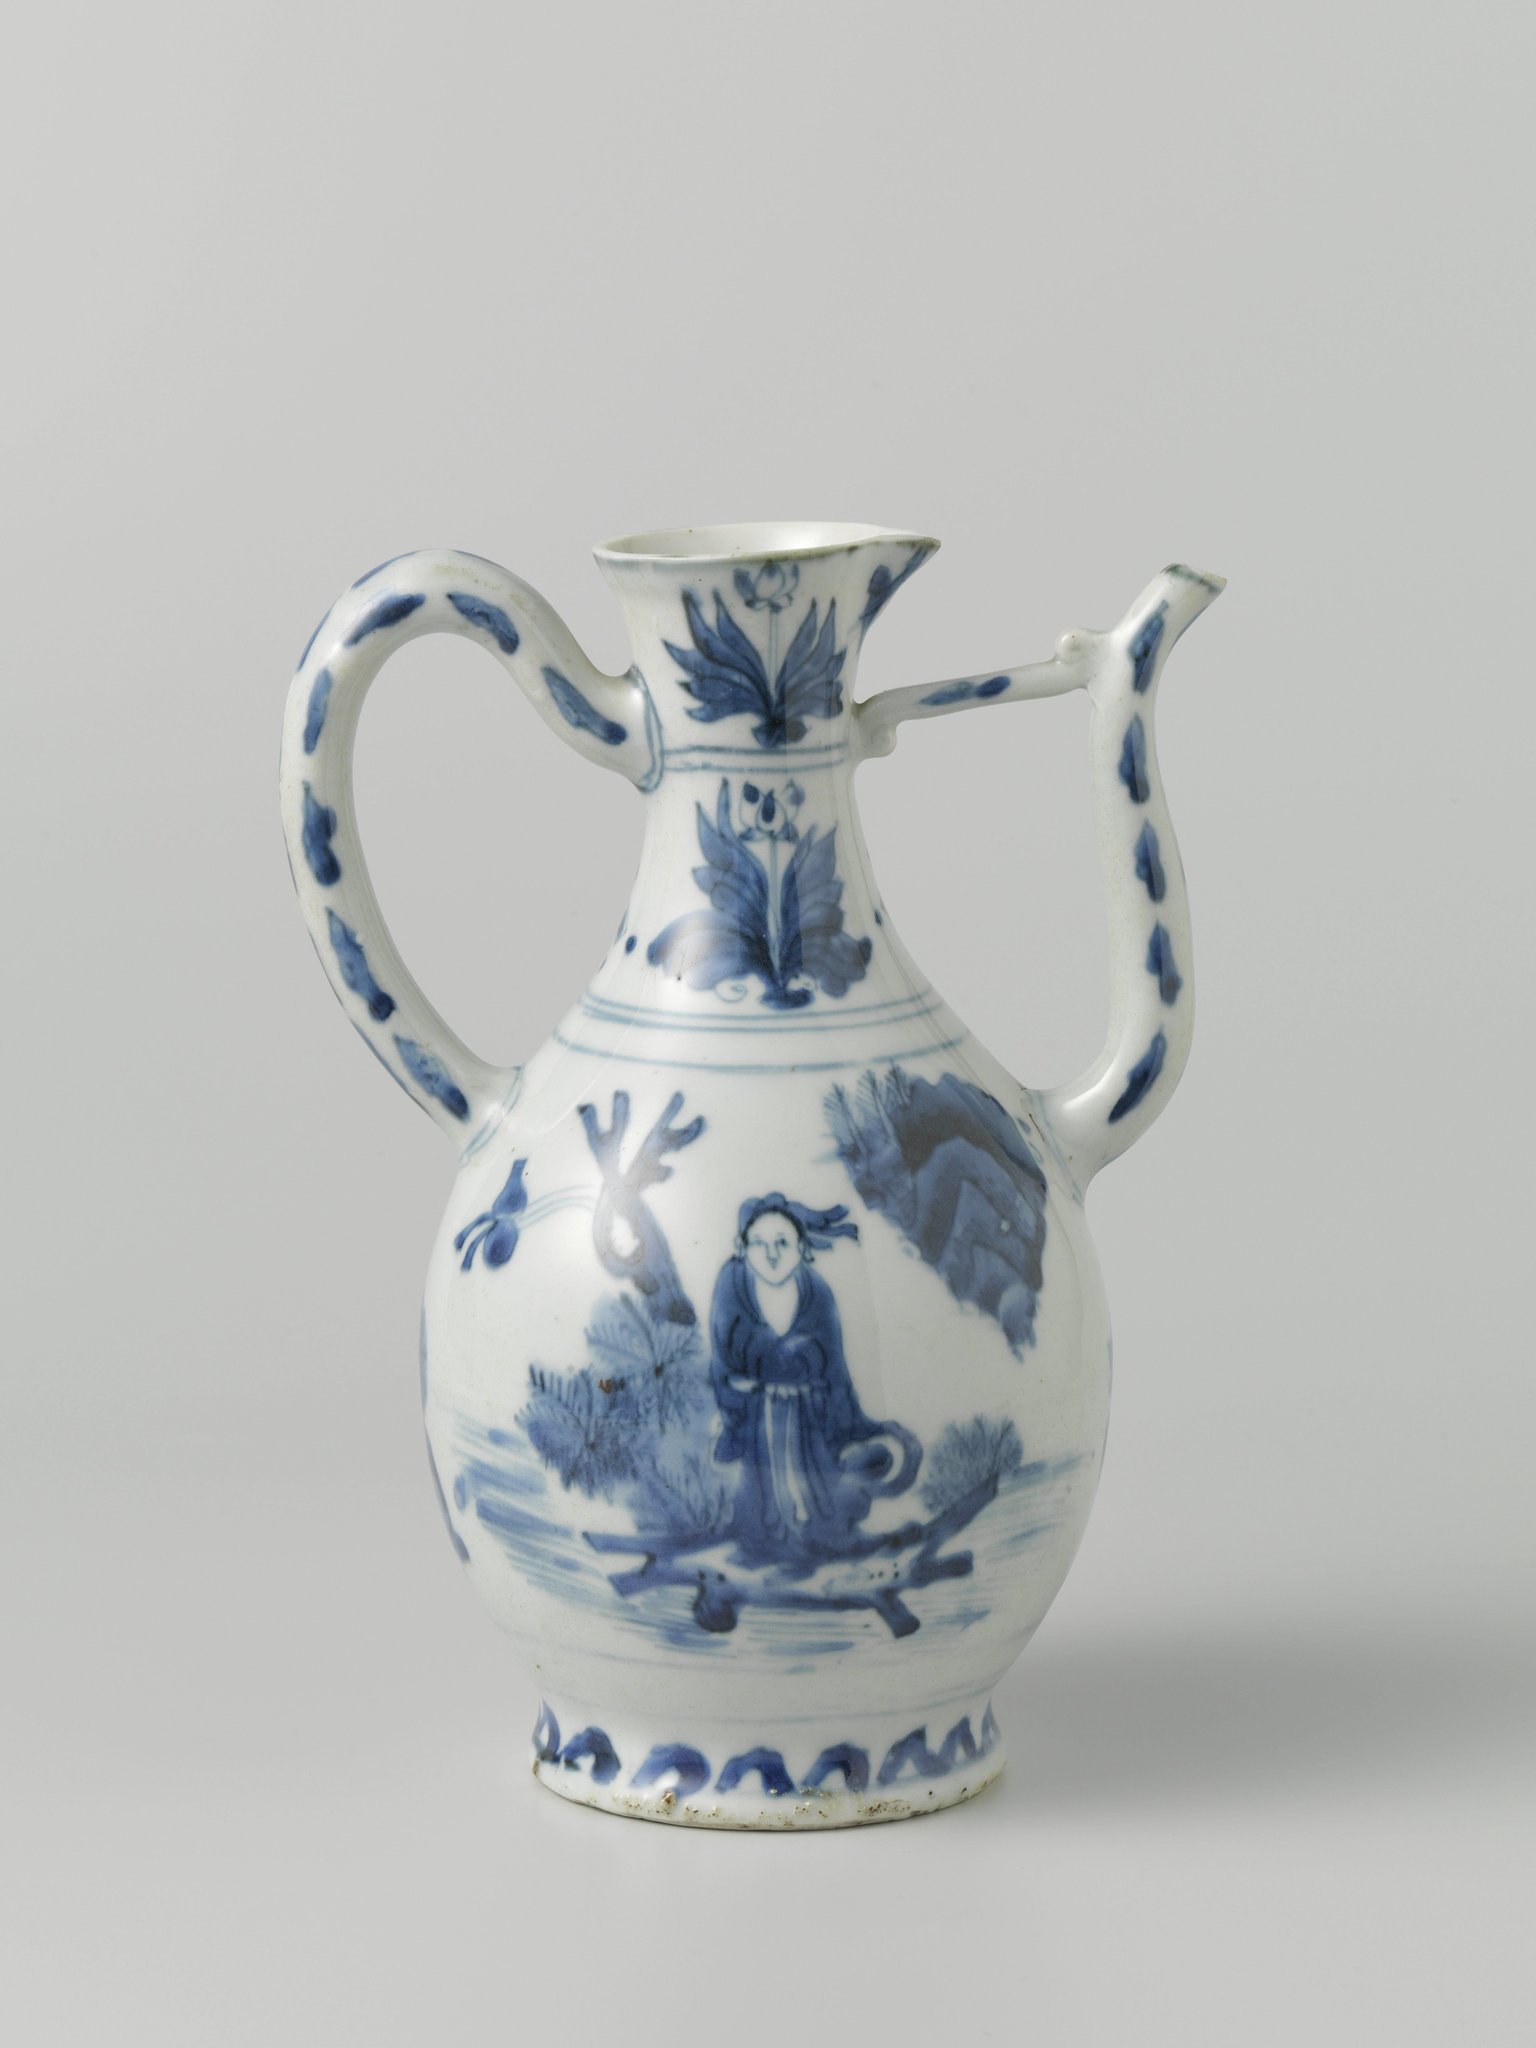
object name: ewer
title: Ewer with a seated figure in a landscape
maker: Anonymous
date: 1635-1645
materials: cobalt, glaze, paint, porcelain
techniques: firing, turning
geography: china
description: This ewer is decorated in blue underglaze with a man on a raft, portraying the diplomat and explorer Zhang Qian (c. 195-114 BCE) from the Han dynasty (206 BCEâ€“220 CE). He was reputed to have gone in search of the Yellow River on a raft, ultimately travelling as far as the Milky Way.